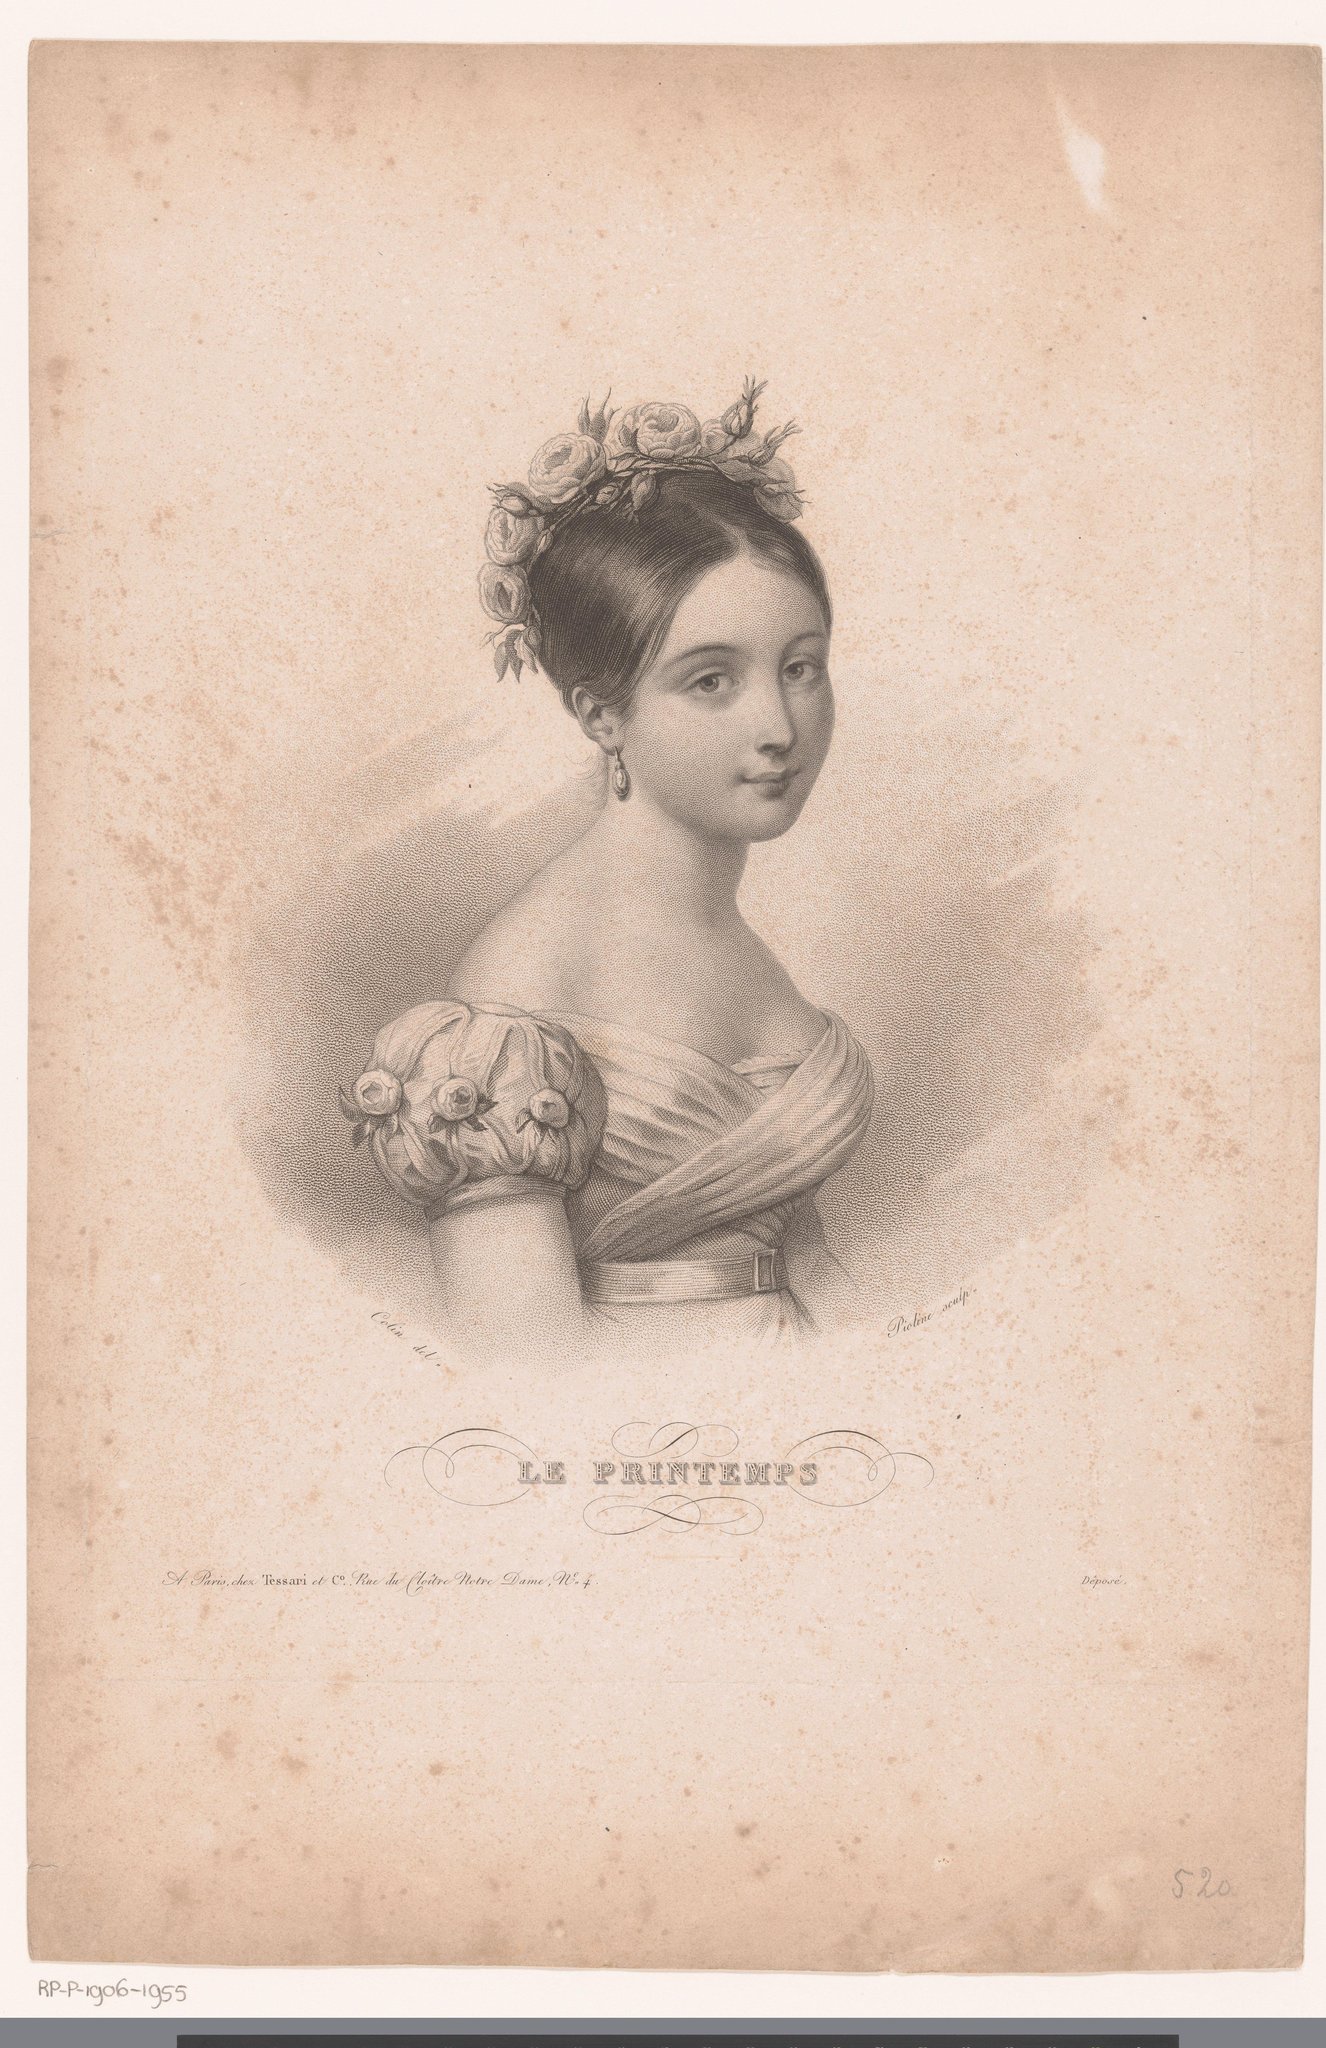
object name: print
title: Le Printemps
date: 1820-1830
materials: paper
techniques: etching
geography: paris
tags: spring, 'ver'; 'primavera' (ripa)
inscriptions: collector's mark: Lugt 2228, : ‘Déposé’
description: Jonge vrouw met rozen in het haar als personificatie van de lente.